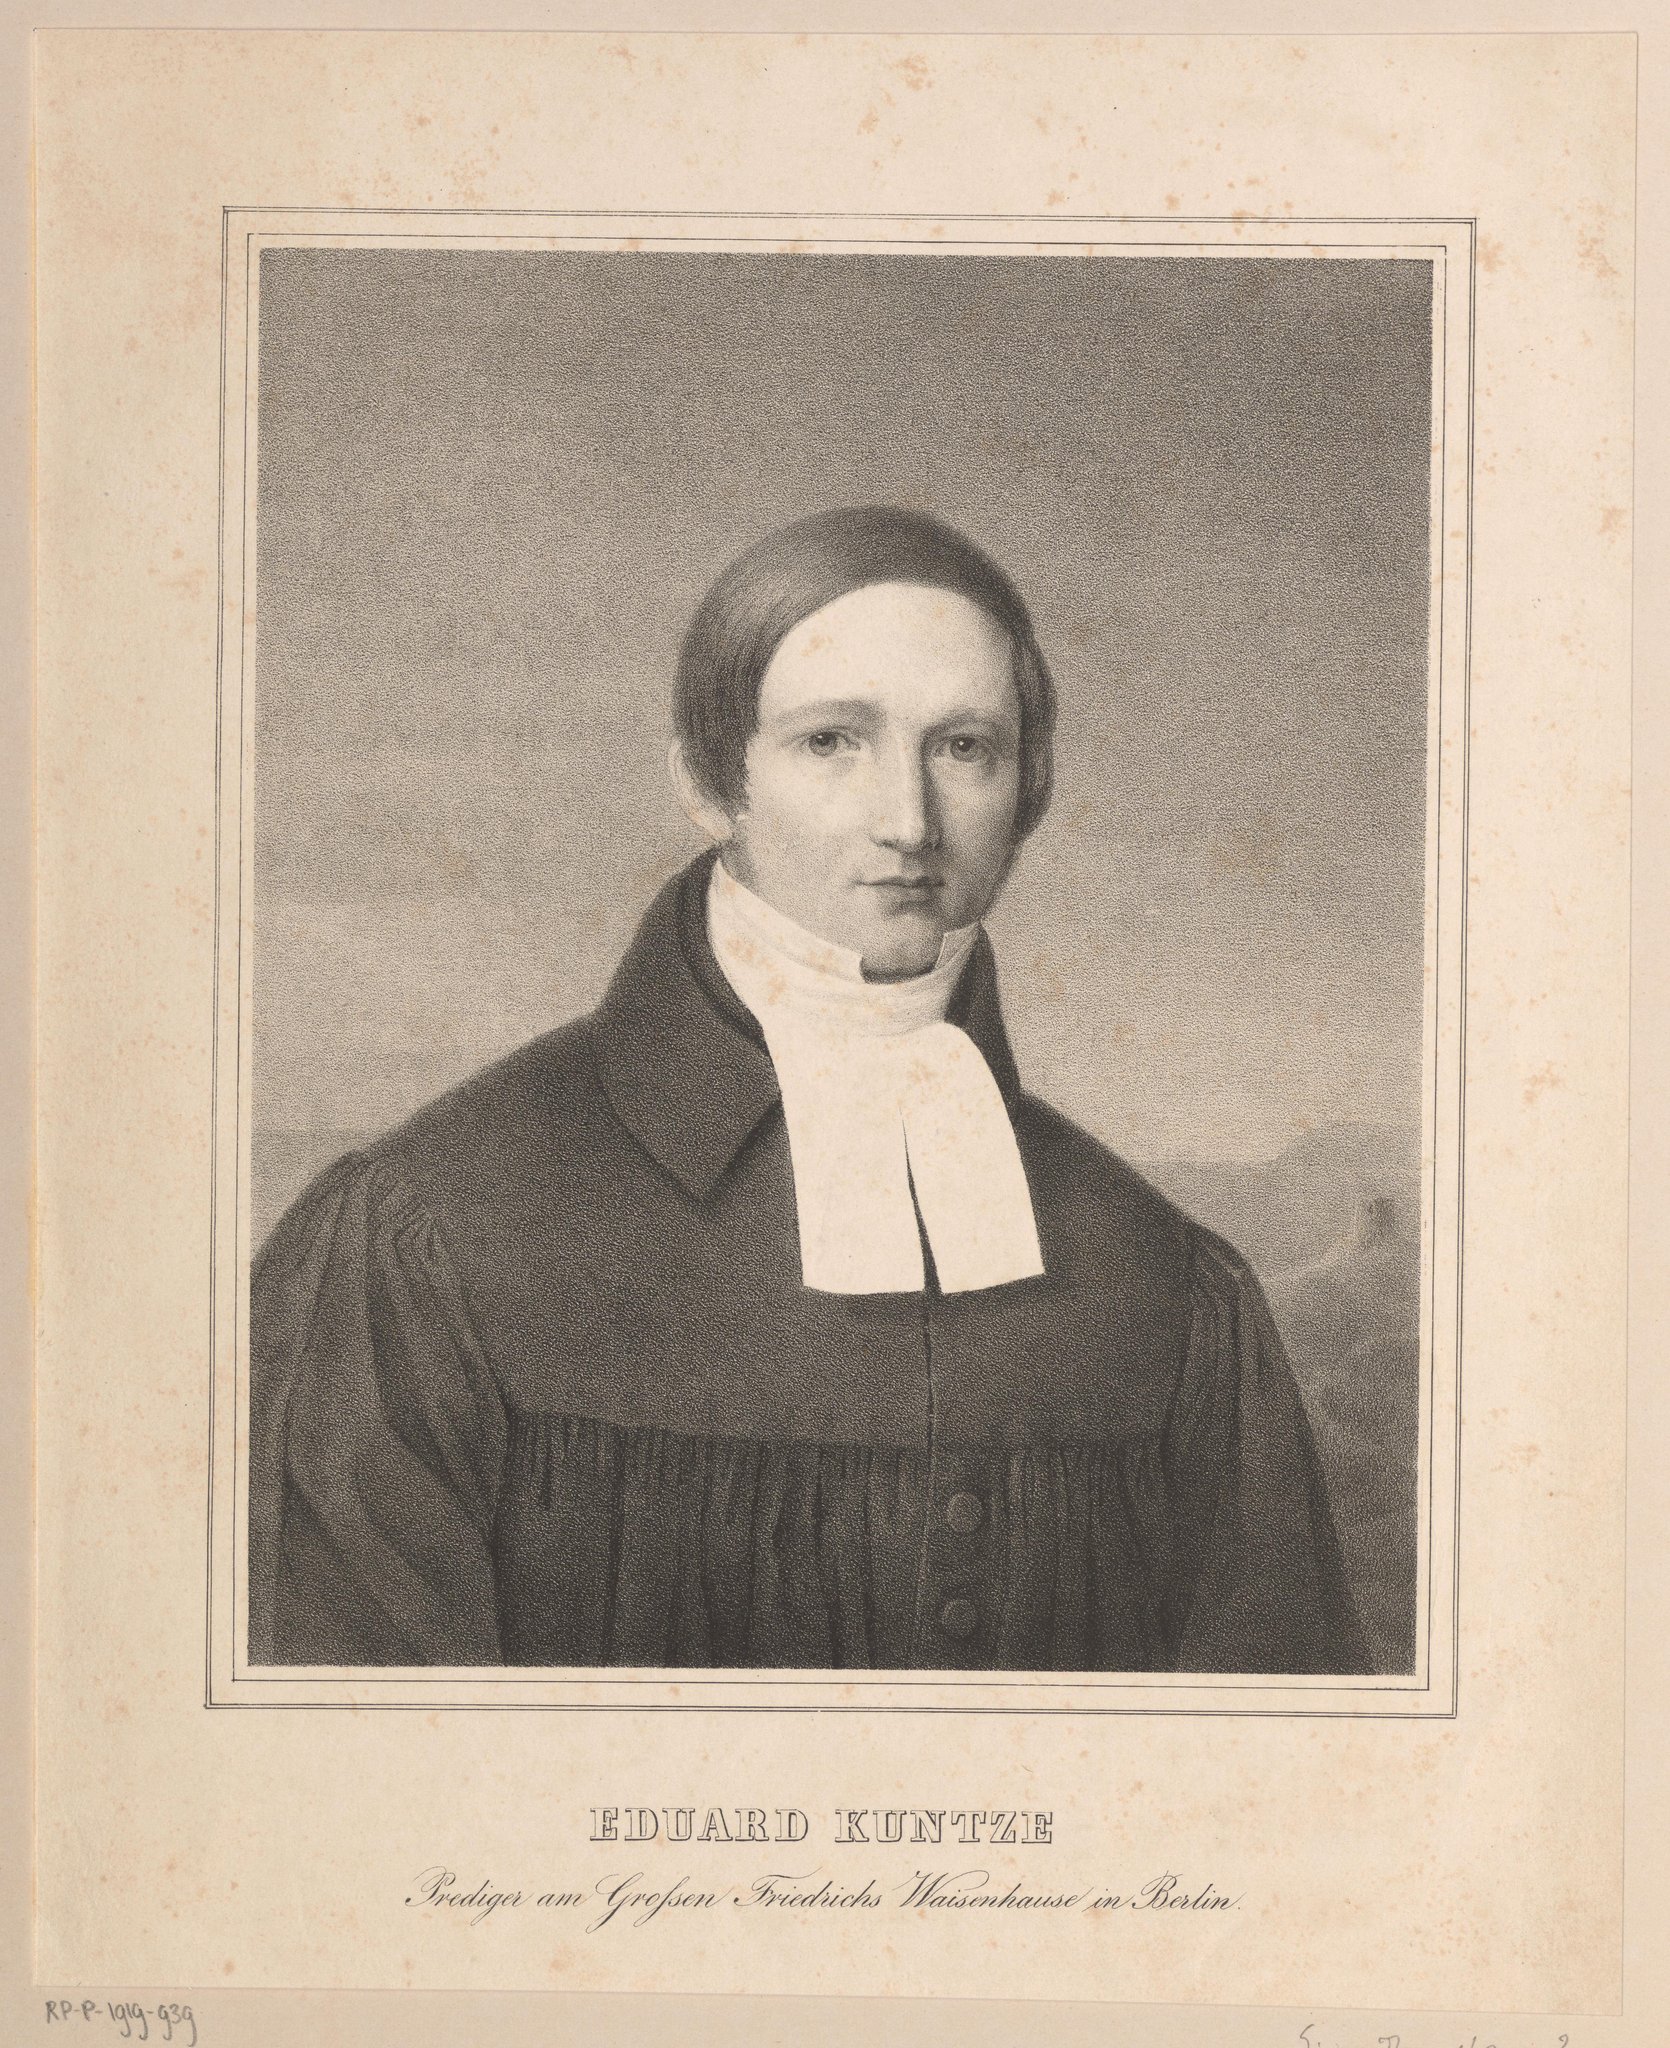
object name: print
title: Portret van Eduard Wilhelm Theodor Kuntze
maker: Anonymous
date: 1809-1862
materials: paper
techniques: lithograph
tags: historical persons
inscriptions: collector's mark: Lugt 2228